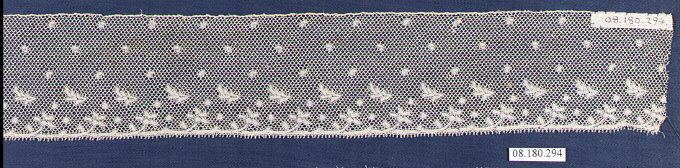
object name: piece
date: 1801-1833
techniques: lace